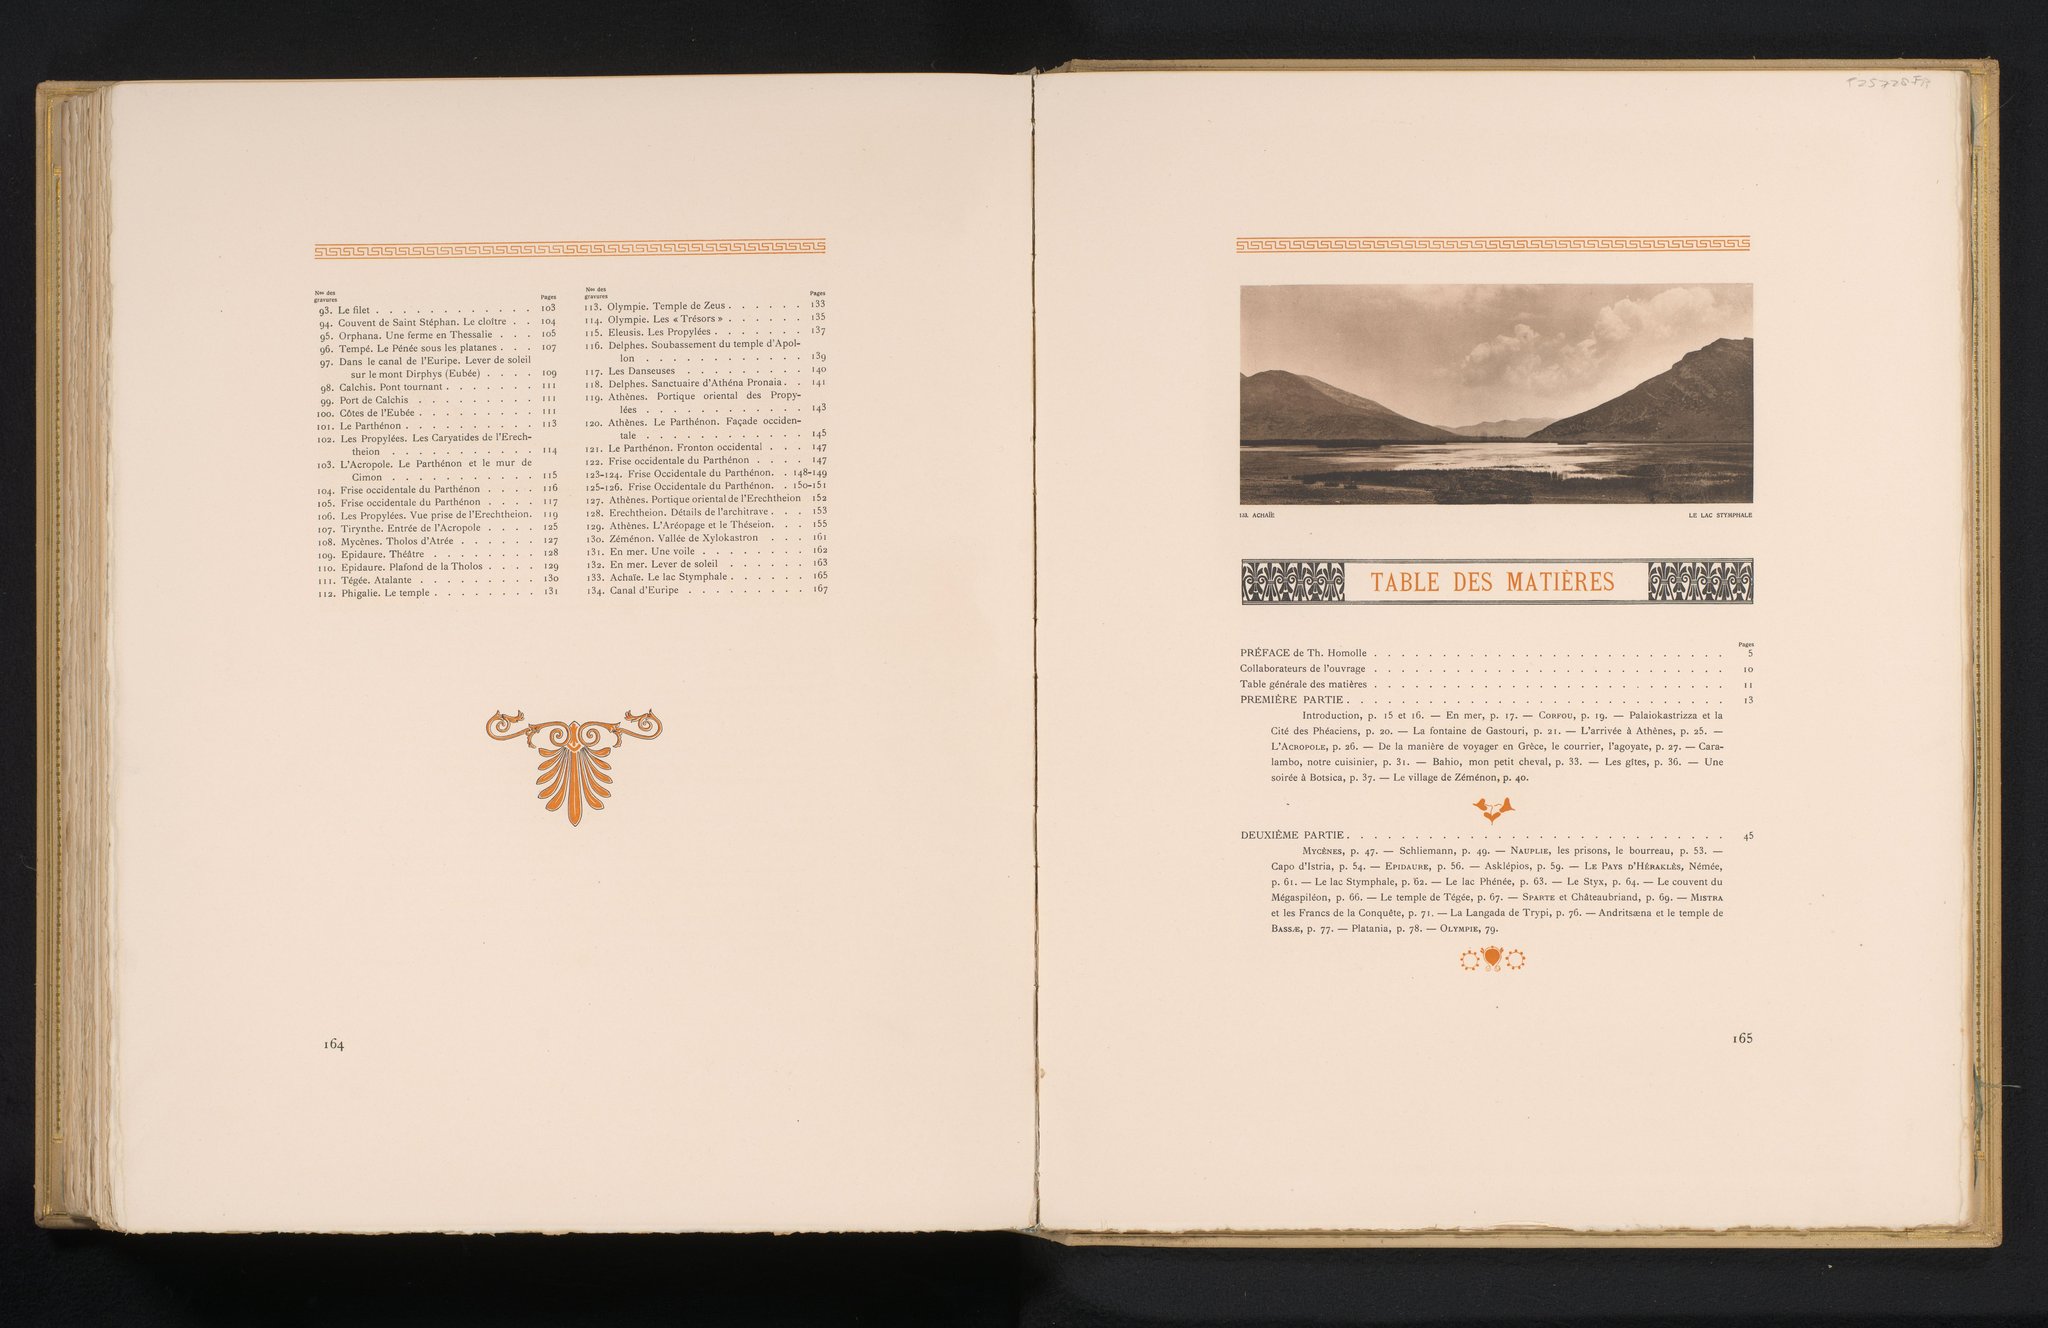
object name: photomechanical print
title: Achaïe, le lac Stymphale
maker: frédéric boissonnas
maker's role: fotograaf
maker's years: 1858-1946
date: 1905-1910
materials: paper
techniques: photograph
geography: arcadië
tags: lake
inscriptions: number: ‘133.’